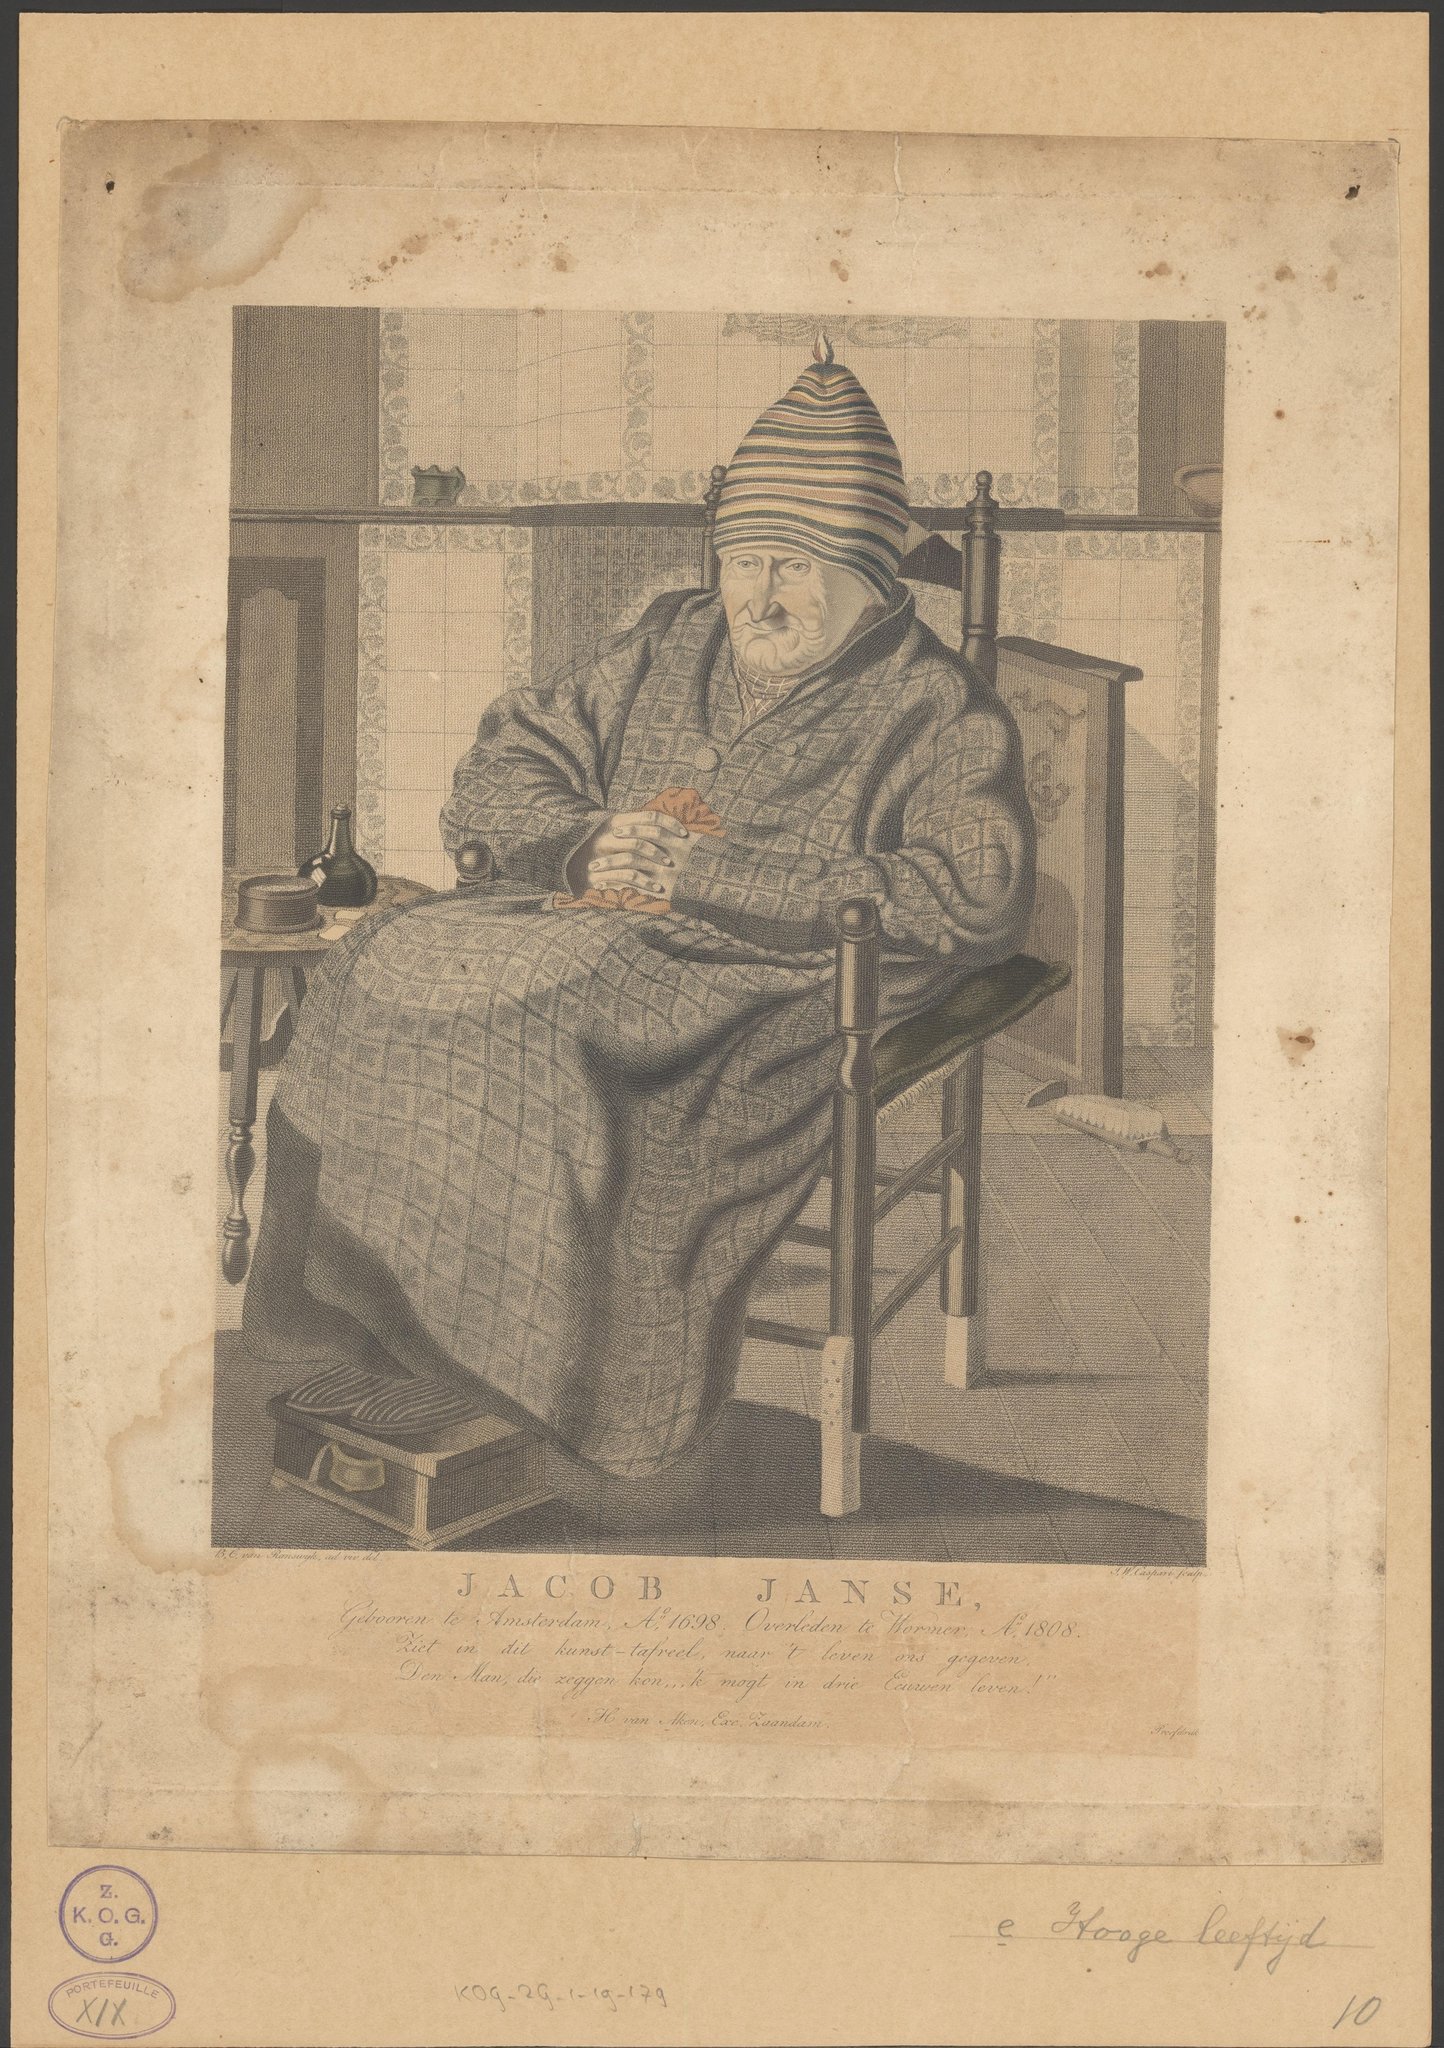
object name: print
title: Jacob Janse, Gebooren te Amsterdam, Ao. 1698. Overleden te Wormer, Ao. 1808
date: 1808-1822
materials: paper, watercolor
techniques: stippled etching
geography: zaandam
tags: amsterdam, old man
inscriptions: collector's mark: Lugt 1641, collector's mark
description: Portret van Jacob Janse (1698-1808), overleden op 110-jarige leeftijd. Leefde in drie eeuwen. Zittend in een stoel in lange jas, muts op het hoofd en de voeten op een stoof. Onderwerpsrubrieken binnen de Atlas Zeden en Gewoonten: Des Menschen Begin, Midden en Einde. Hooge leeftijd.